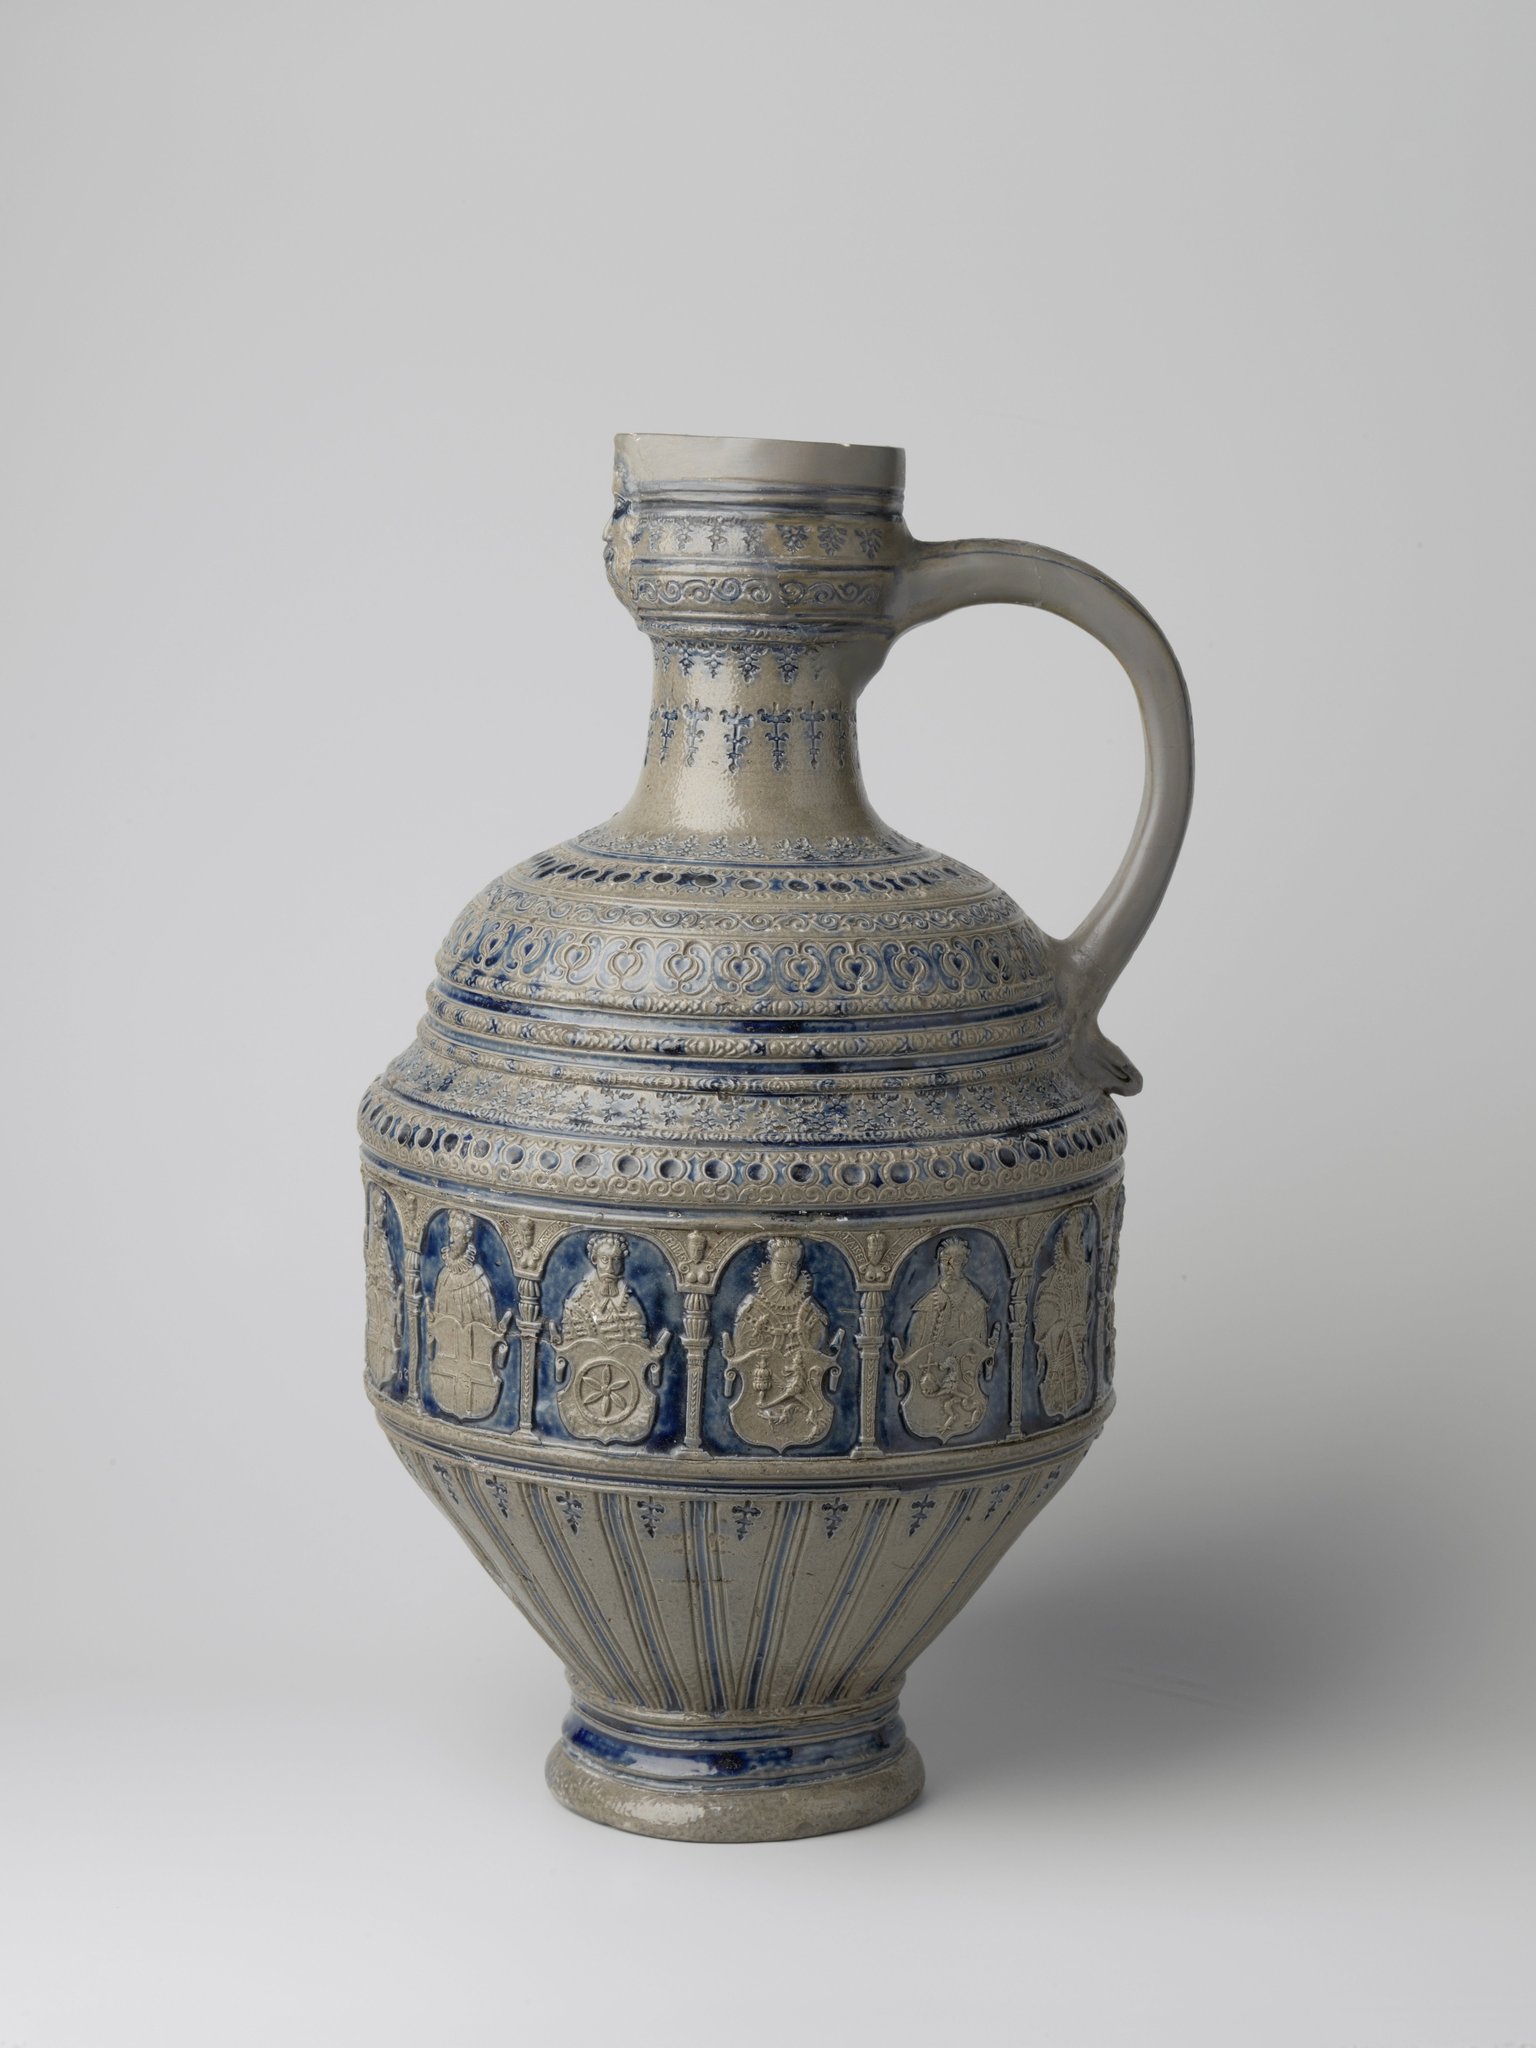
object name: ewer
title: Jug with a representation of the electors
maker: jan baldems mennicken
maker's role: potter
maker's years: 1568-1612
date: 1602-1620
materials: cobalt, glaze, stoneware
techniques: printing, firing, forming, relief, turning, vitrification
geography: raeren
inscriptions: date: ‘1602’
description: Kan van steengoed op hoge voet met een cilindrisch lichaam, ronde schouder en smalle nek met een geknepen tuit. Het C-vormige oor is bevestigd aan de nek en de schouder. Profielen op de nek, buik en voet. Gedeeltelijk bedekt met kobaltblauw. Op de buik in reliëf een gedrukte en opgelegde band met bogen. Onder elke boog is een keurvorst met zijn respectievelijke wapen afgebeeld. In één vak de datum '1602'. Het onderste deel van de buik loopt schuin af naar de voet en is bedekt met ingegrifte vakken met een gestempelde bloemrank. De schouder is iets smaller dan de buik en is versierd met banden met verschillende gestempelde decoraties. De voorzijde van de nek met een baardman. Krulwerk op het oor. Raeren.